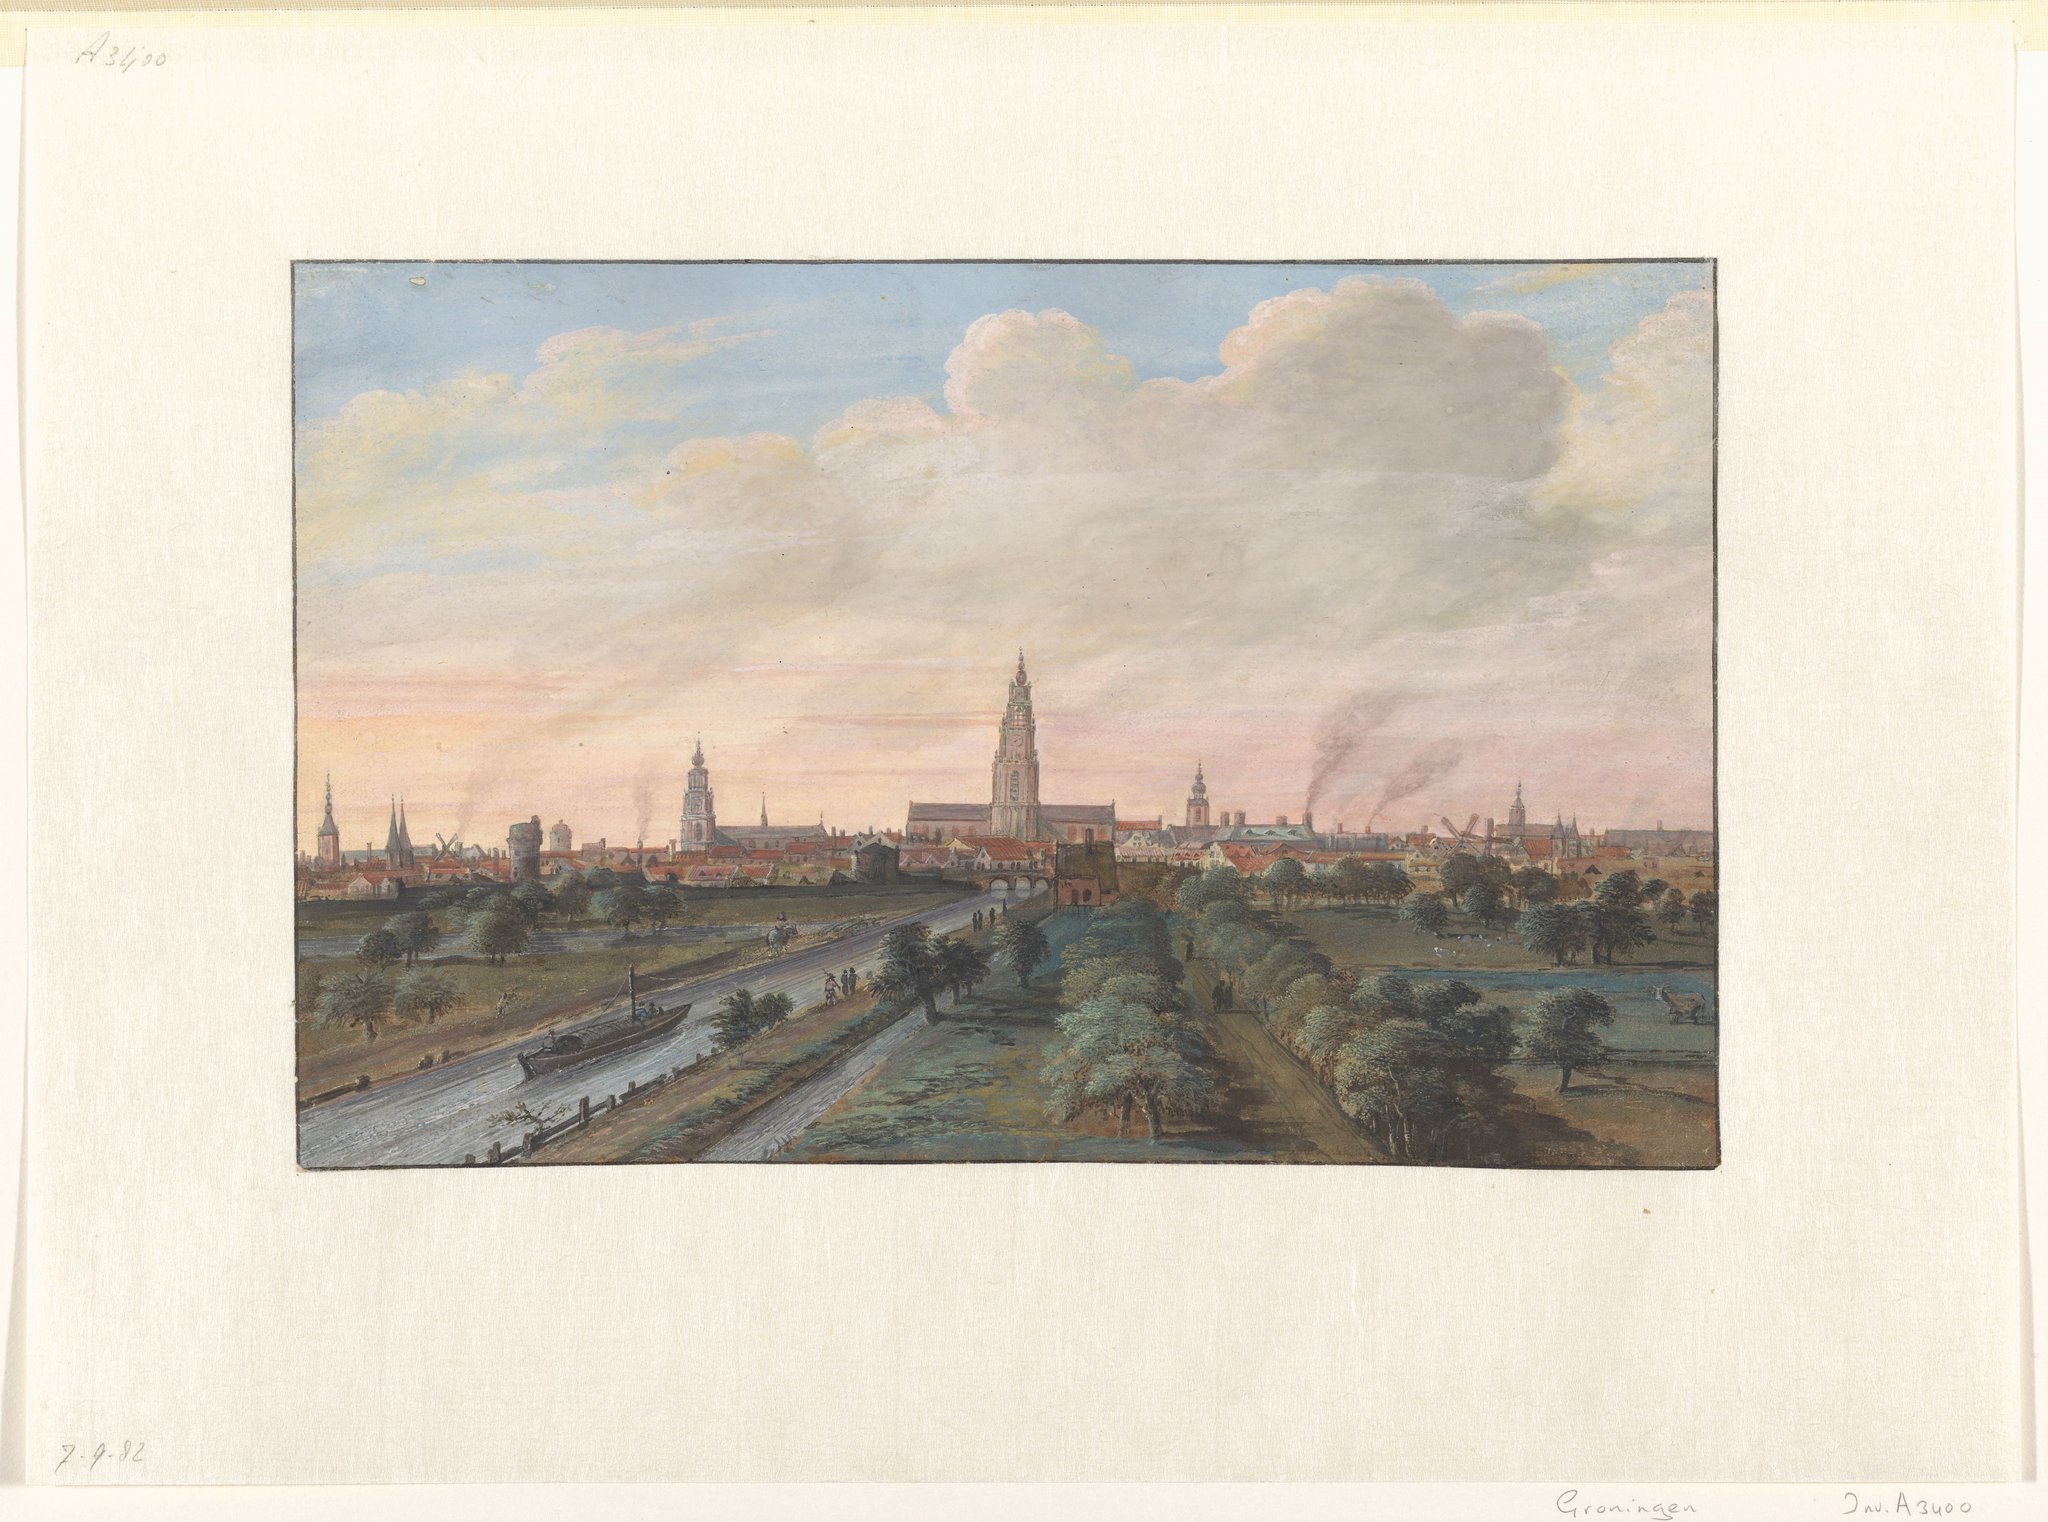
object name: drawing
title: Gezicht op de stad Groningen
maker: gerrit battem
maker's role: draughtsman, painter, print maker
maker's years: 1636-1684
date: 1646-1684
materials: paint, gouache, paper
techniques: brush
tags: prospect of city, town panorama, silhouette of city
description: Gezicht op Groningen met een hoge toren aan een kruiskerk. Links een kleinere kerk met toren. Een vaart loopt op de stad toe.